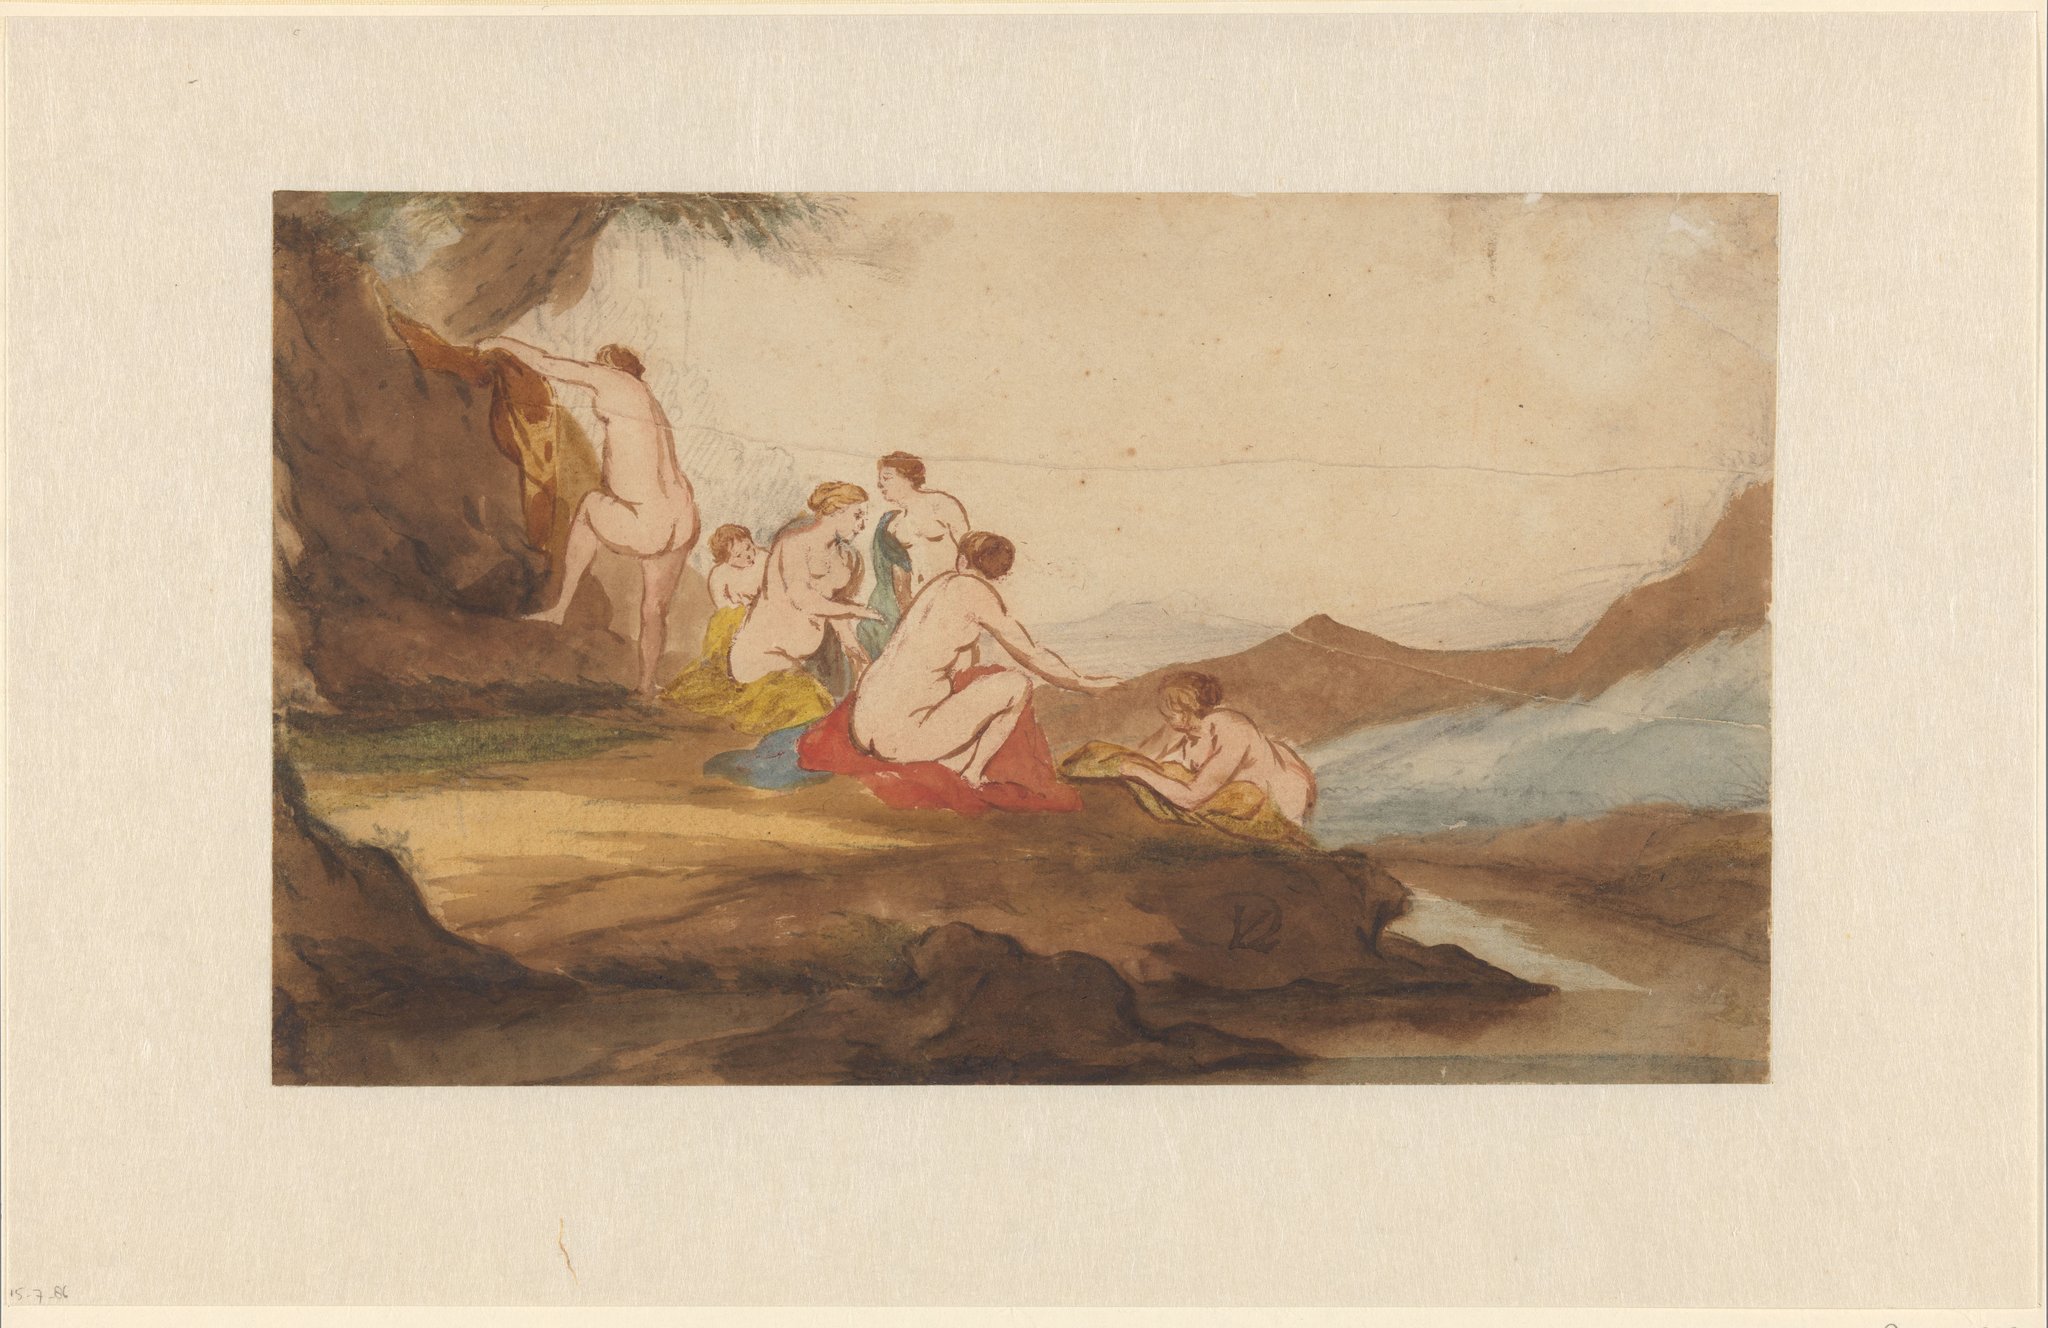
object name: watercolor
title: Women Bathing in a Landscape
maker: dirck van der lisse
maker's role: draughtsman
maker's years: 1607-1669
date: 1617-1669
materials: chalk, paper, watercolor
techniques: brush, drawing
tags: washing and bathing - aa - in the open air, diana bathing with her nymphs